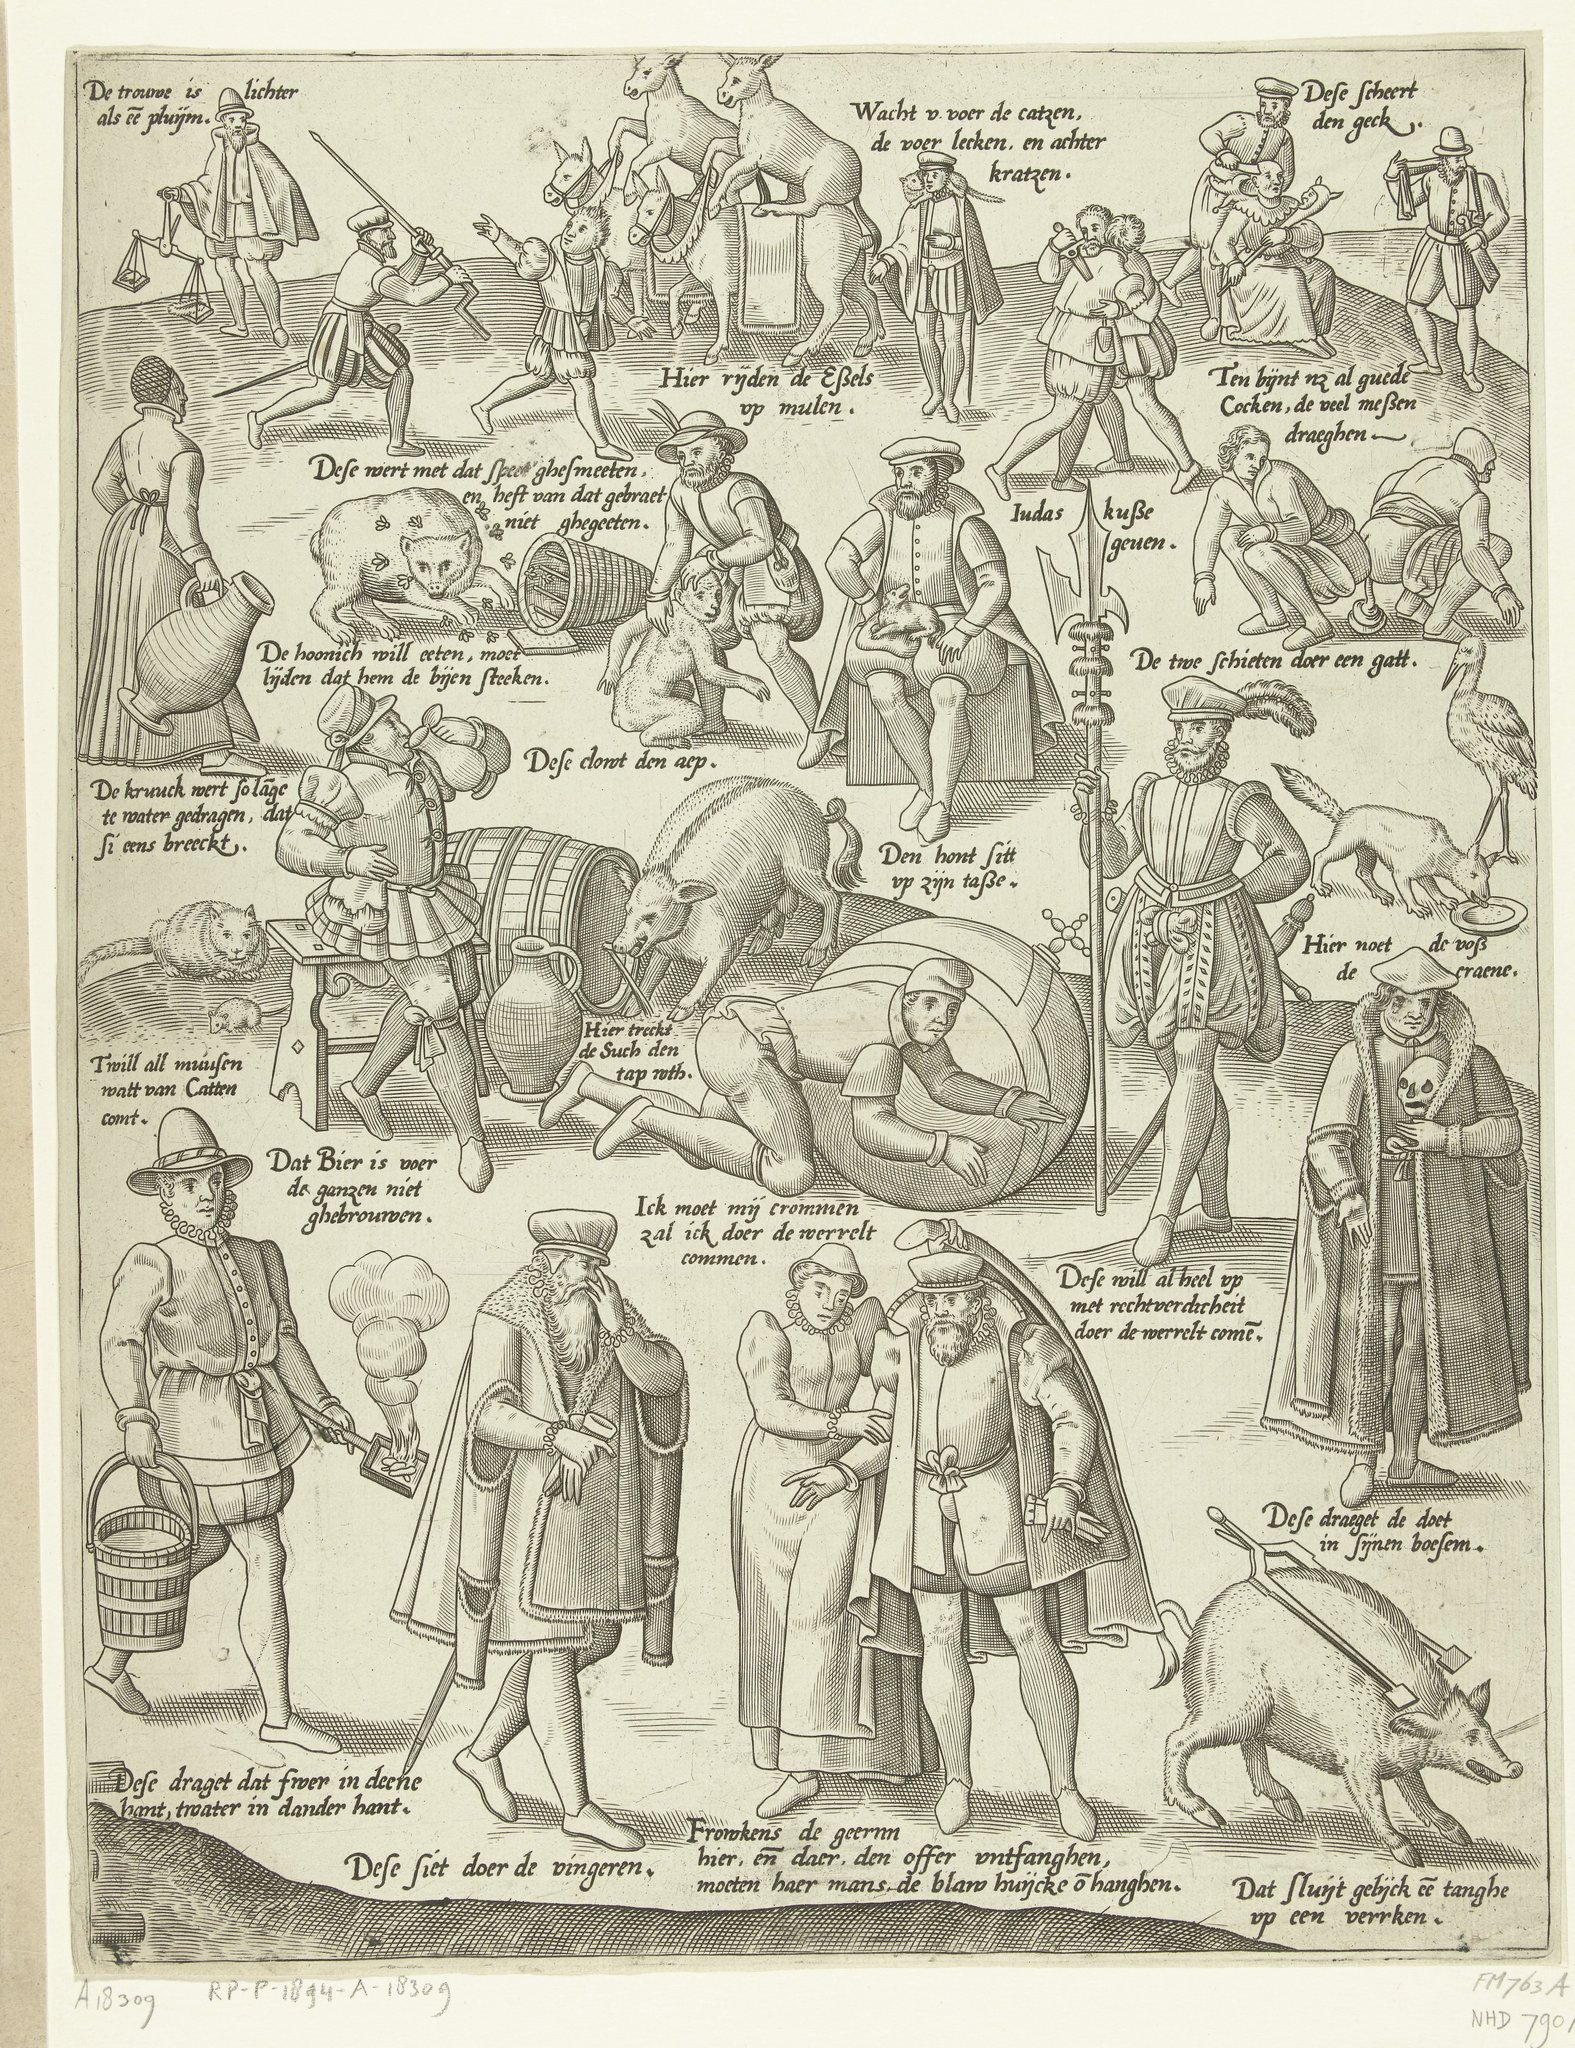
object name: print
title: De Blauwe Huyck (blad 3)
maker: joannes van doetechum (i)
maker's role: print maker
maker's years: 1528-1605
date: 1577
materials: paper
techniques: engraving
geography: low countries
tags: proverbs, sayings, etc.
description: zie: Gentsche Bijdragen VI, 1939-1940, p. 186.